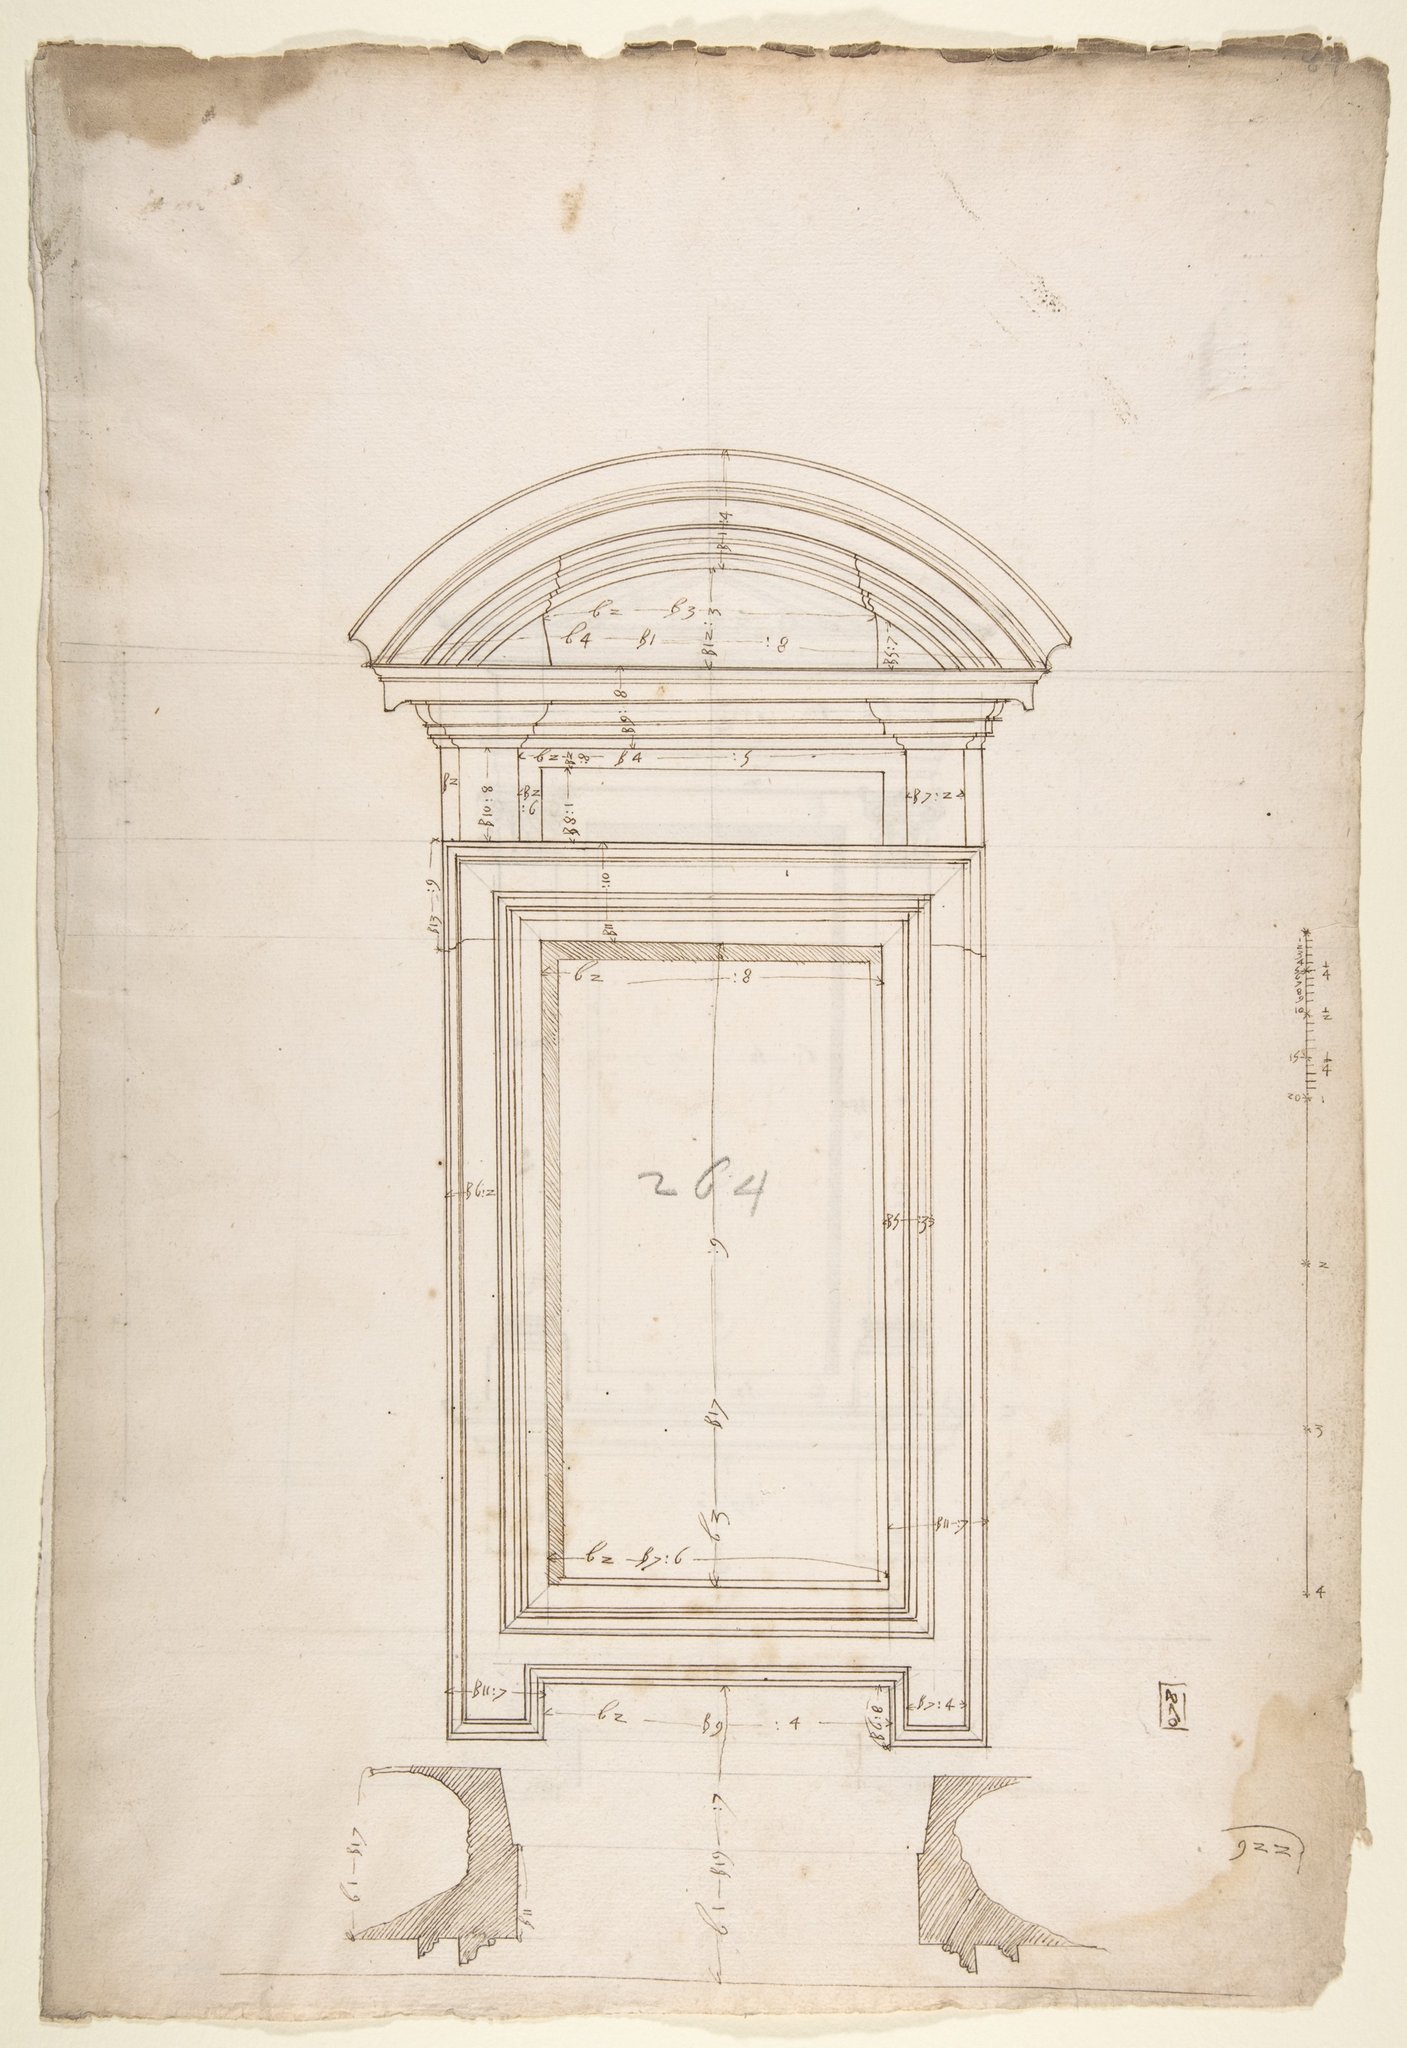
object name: drawing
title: San Lorenzo, New Sacristy, window, plan; elevation (recto) San Lorenzo, New Sacristy, window, plan; elevation (verso)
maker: anonymous, french, 16th century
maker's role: draftsman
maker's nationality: french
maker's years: 1500-1600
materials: chalk, ink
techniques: incising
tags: architecture,windows